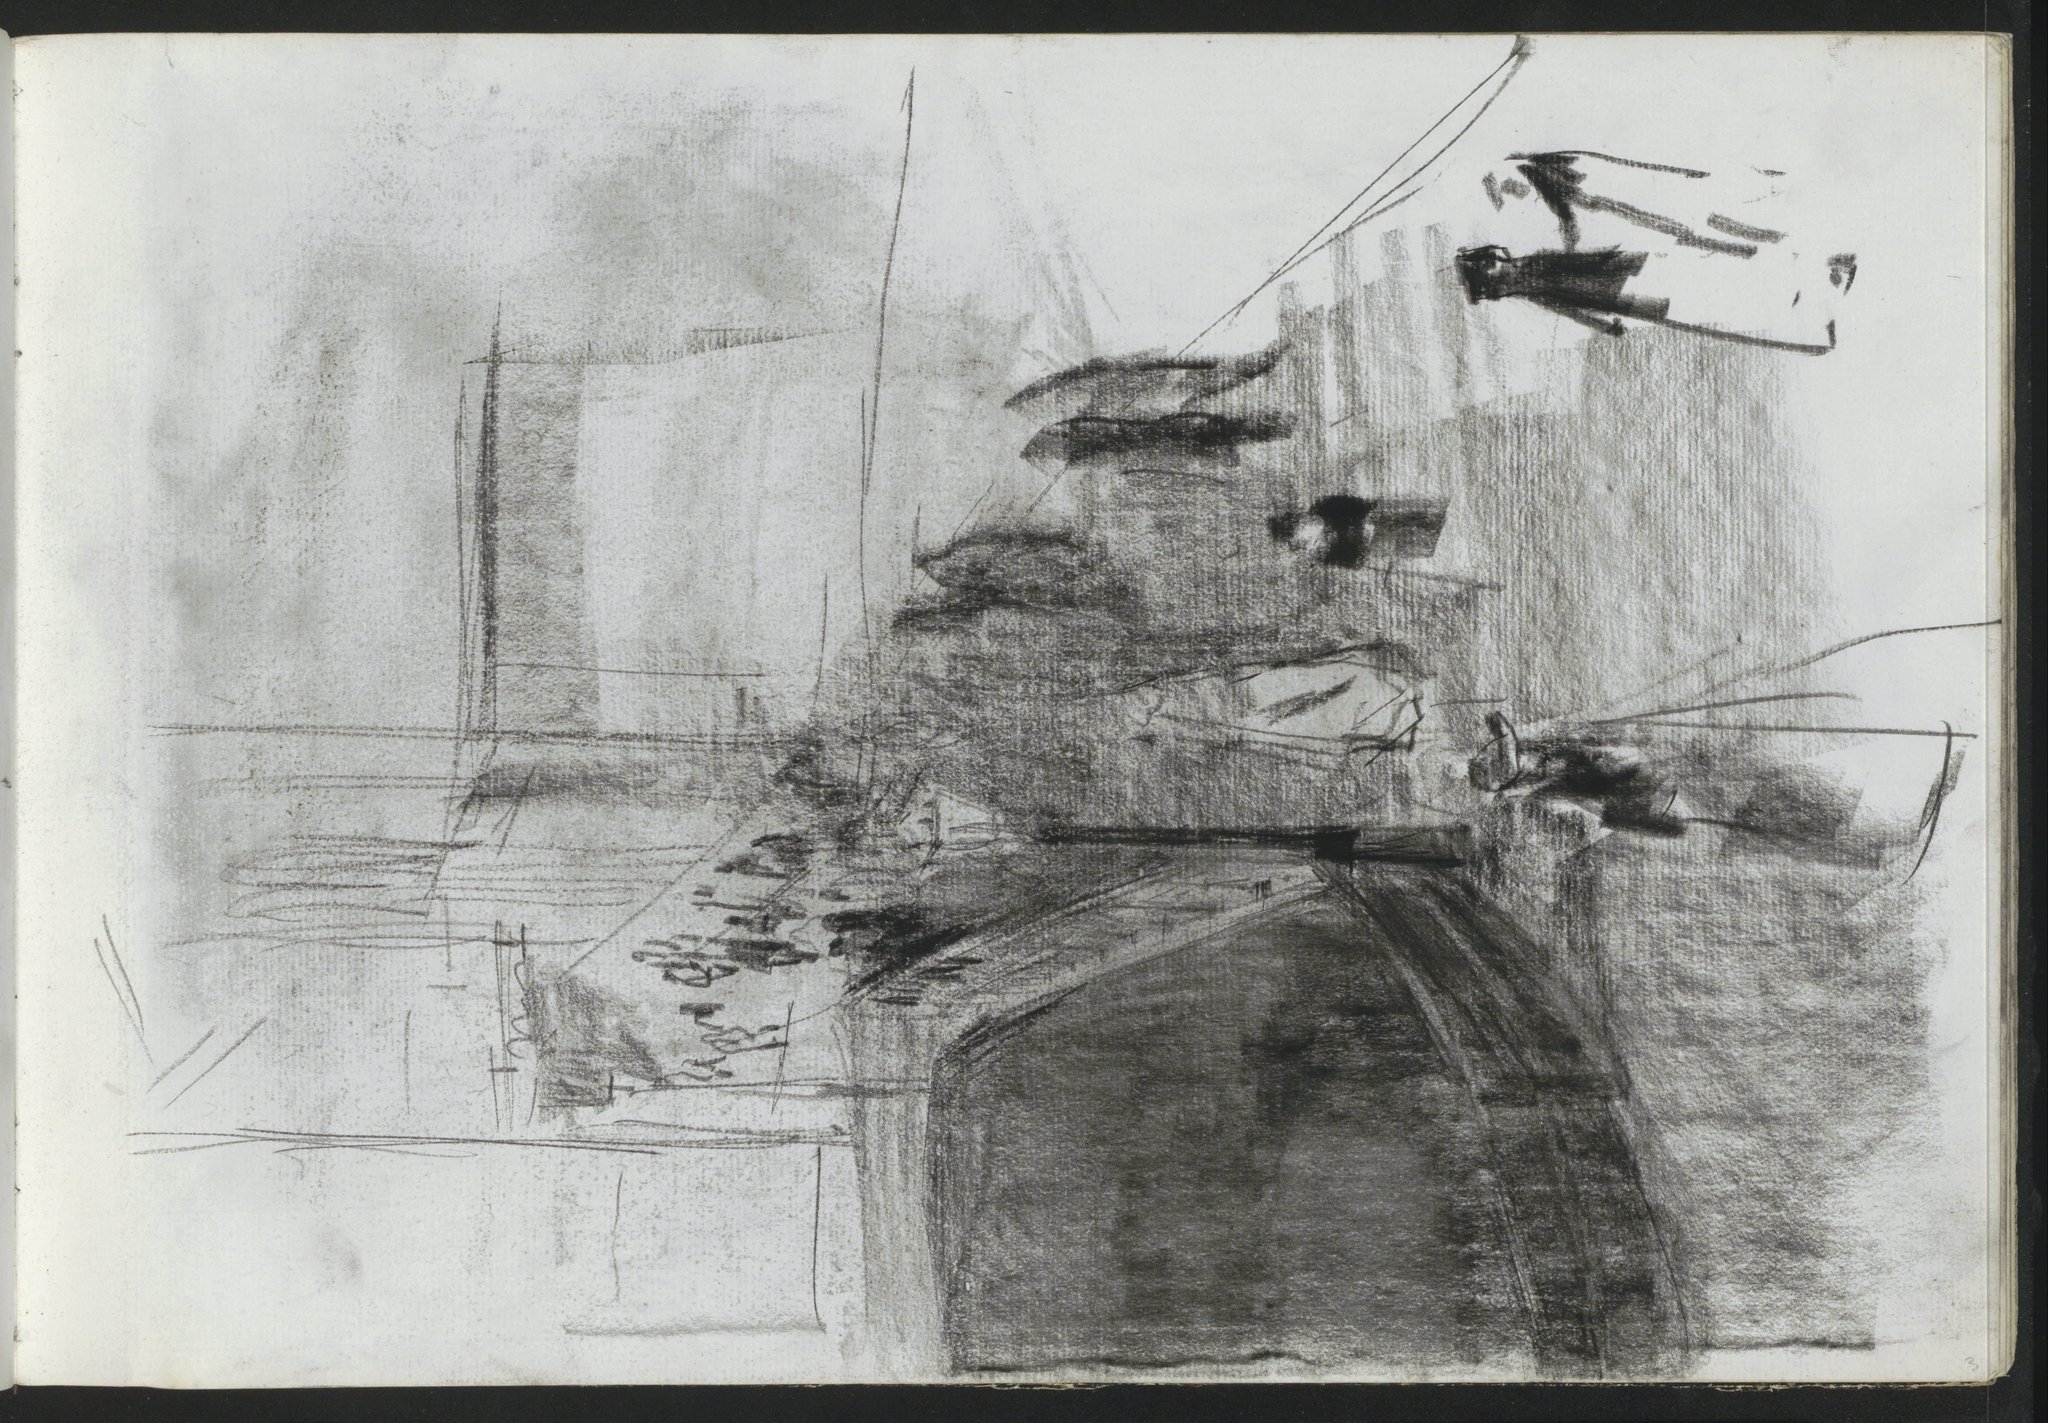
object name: sketchbook leaf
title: Brug over de Herengracht te Amsterdam, ter hoogte van de Gasthuismolensteeg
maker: isaac israels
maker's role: draughtsman, painter, print maker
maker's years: 1865-1934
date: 1886-1934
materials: chalk, paper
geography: amsterdam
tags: urban housing, bridge in city across river, canal, etc. (+ city(-scape) with figures, staffage)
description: Gezien vanuit Herengracht 232. Blad 3 recto uit schetsboek LXX met 17 bladen.